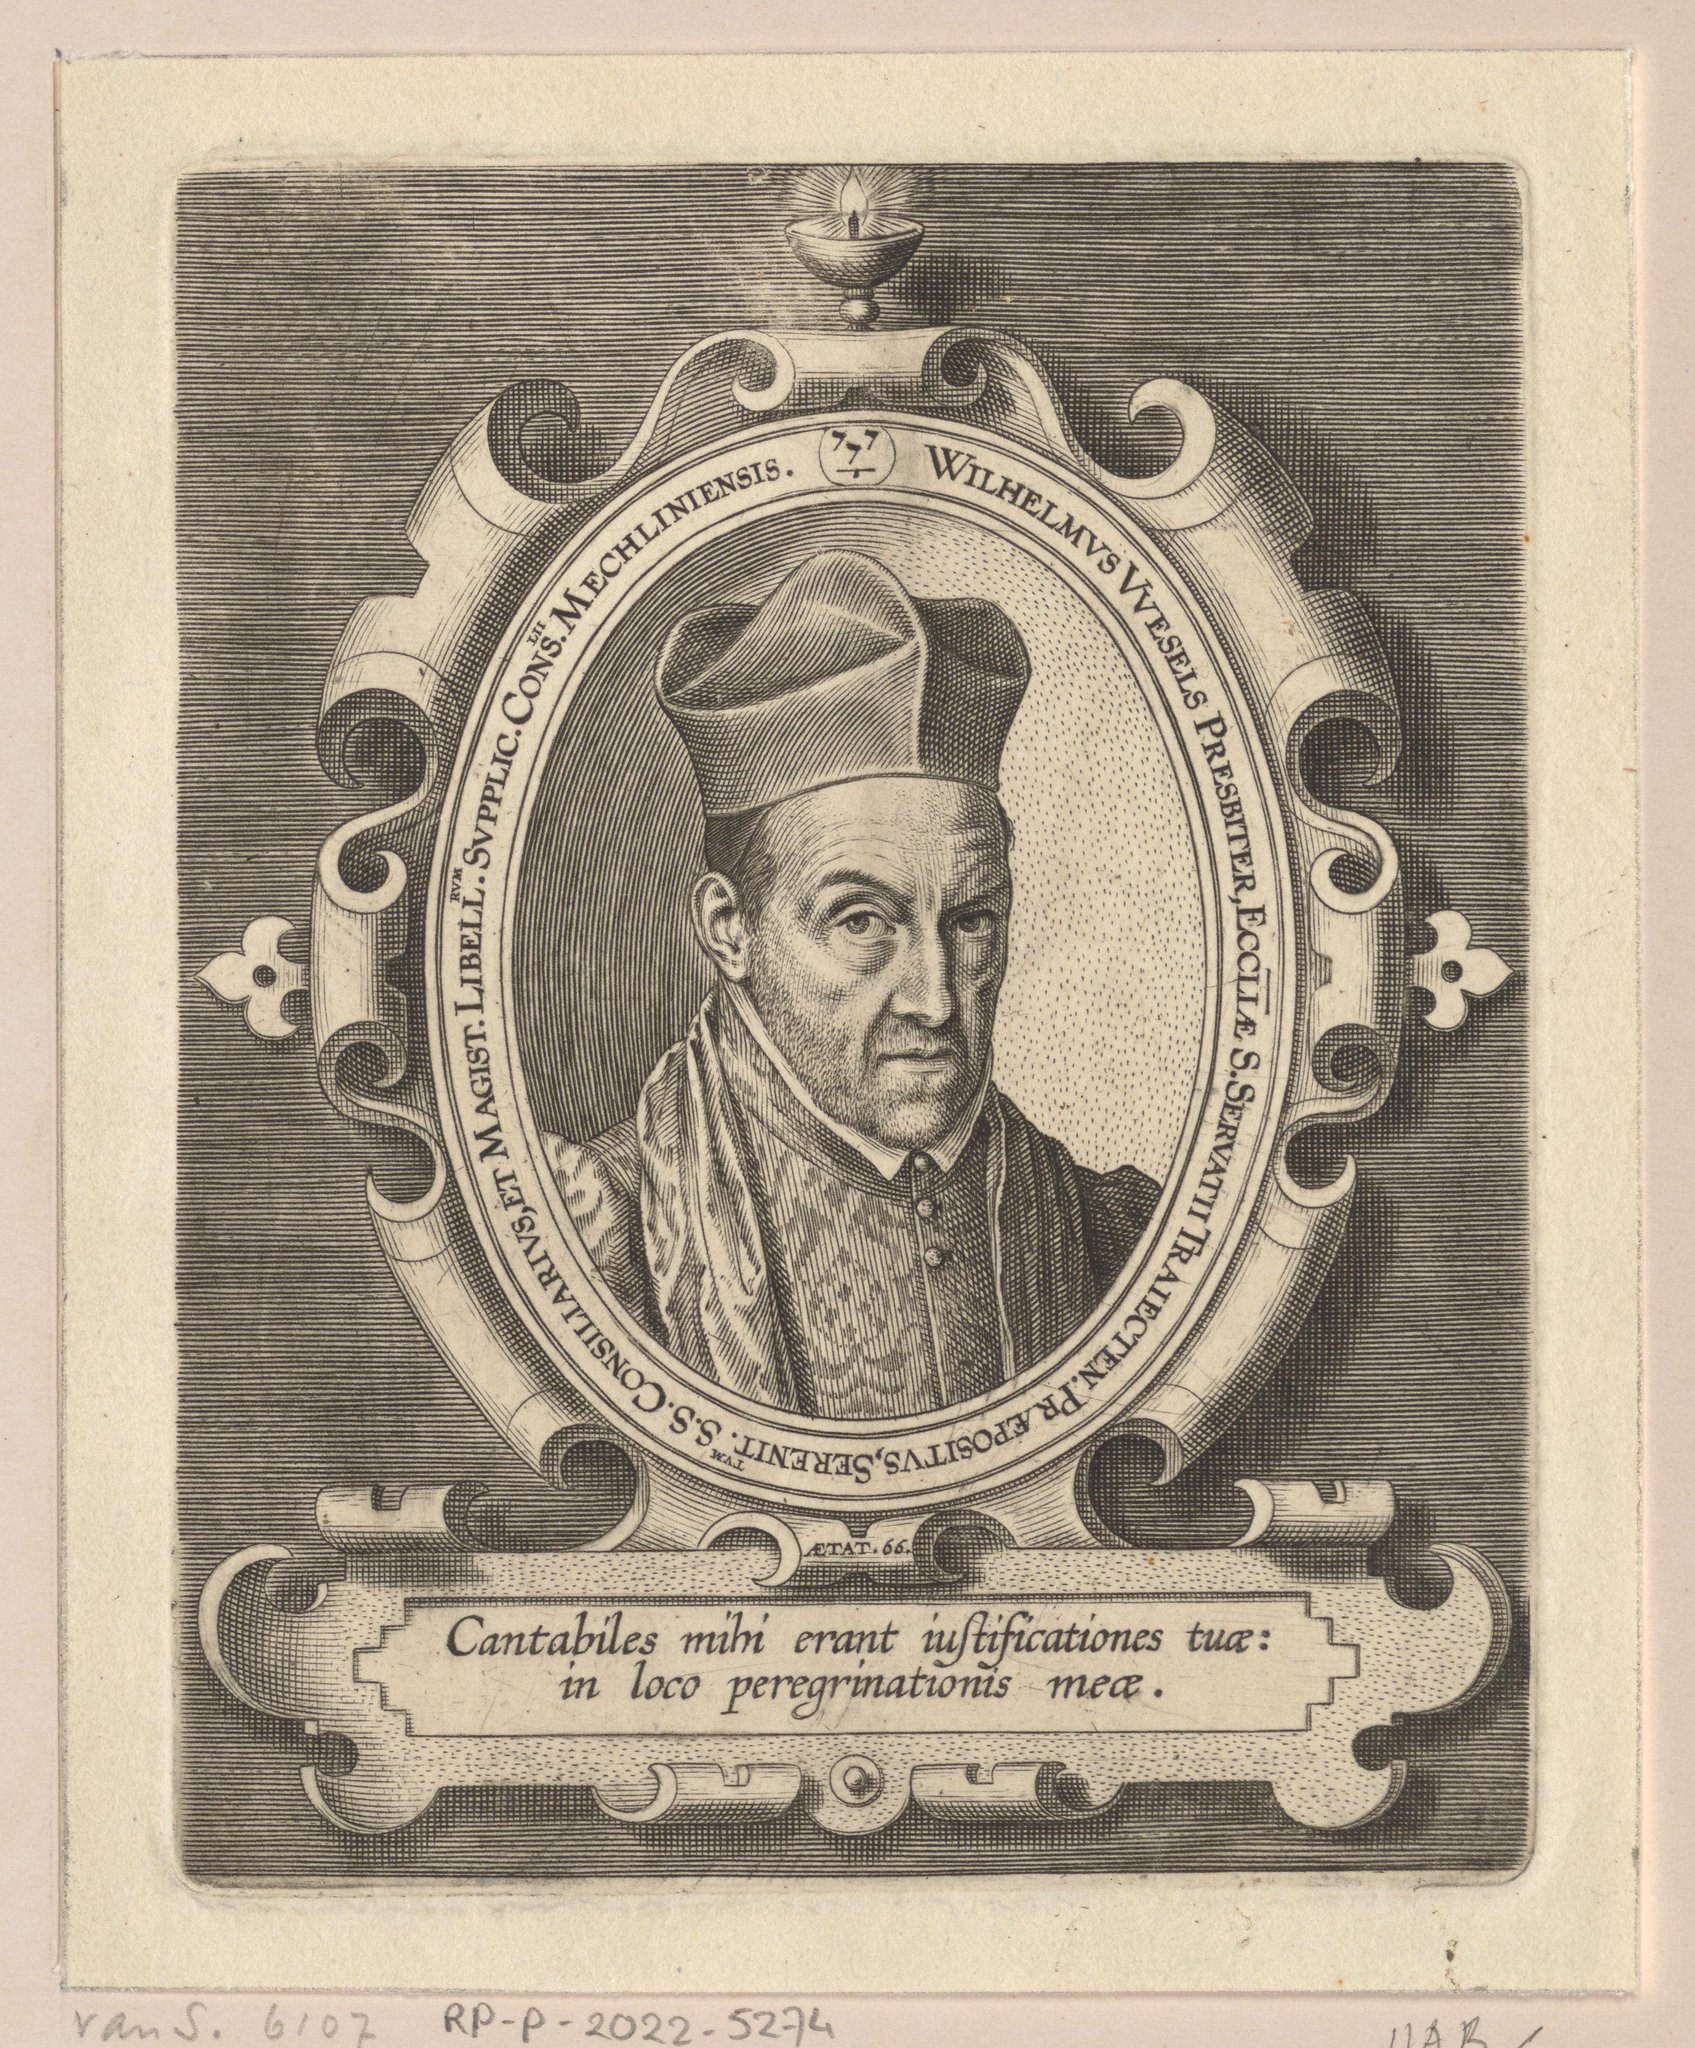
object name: print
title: Portret van Willem Wesels op 66-jarige leeftijd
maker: cornelis galle (ii)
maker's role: print maker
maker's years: 1615-1678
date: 1650-1678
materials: paper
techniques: engraving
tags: historical persons